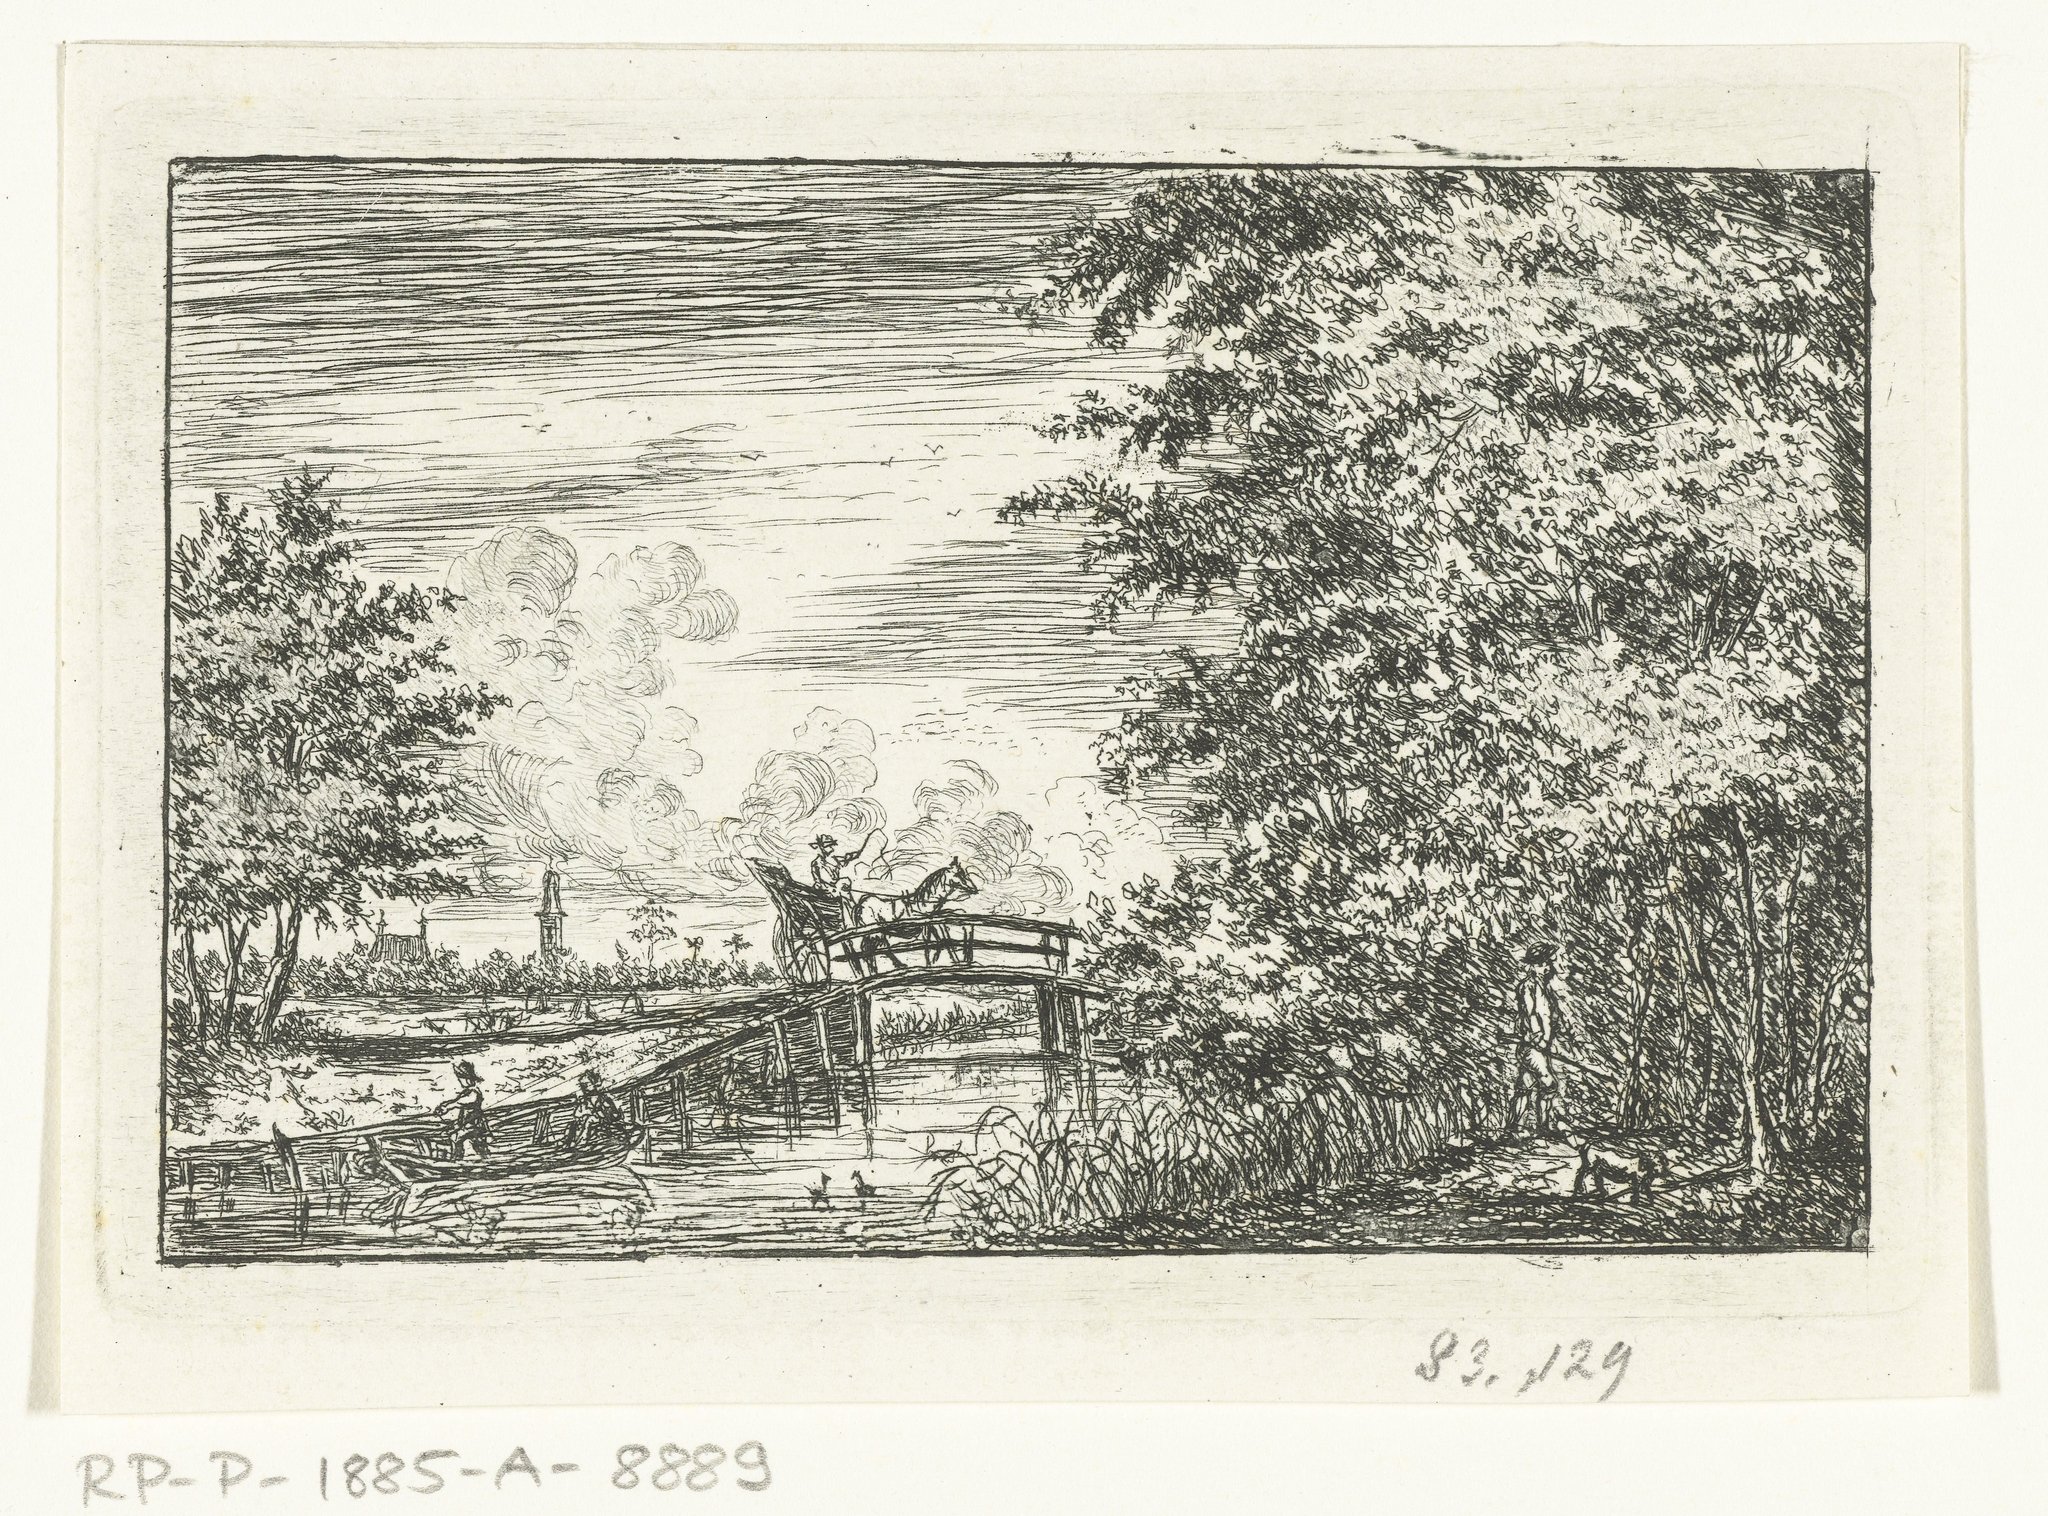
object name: print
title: Rivierlandschap met brug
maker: nicolaas albrecht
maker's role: painter, print maker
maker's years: -1771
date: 1760-1771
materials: paper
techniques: drypoint, etching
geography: netherlands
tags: landscapes with waters, waterscapes, seascapes (in the temperate zone)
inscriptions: collector's mark: Lugt 2228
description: Links op de voorgrond een bootje met twee personen. Rechts een jager met zijn hond in het bos. Op de achtergrond in het midden een brug, waarover een koets rijdt.